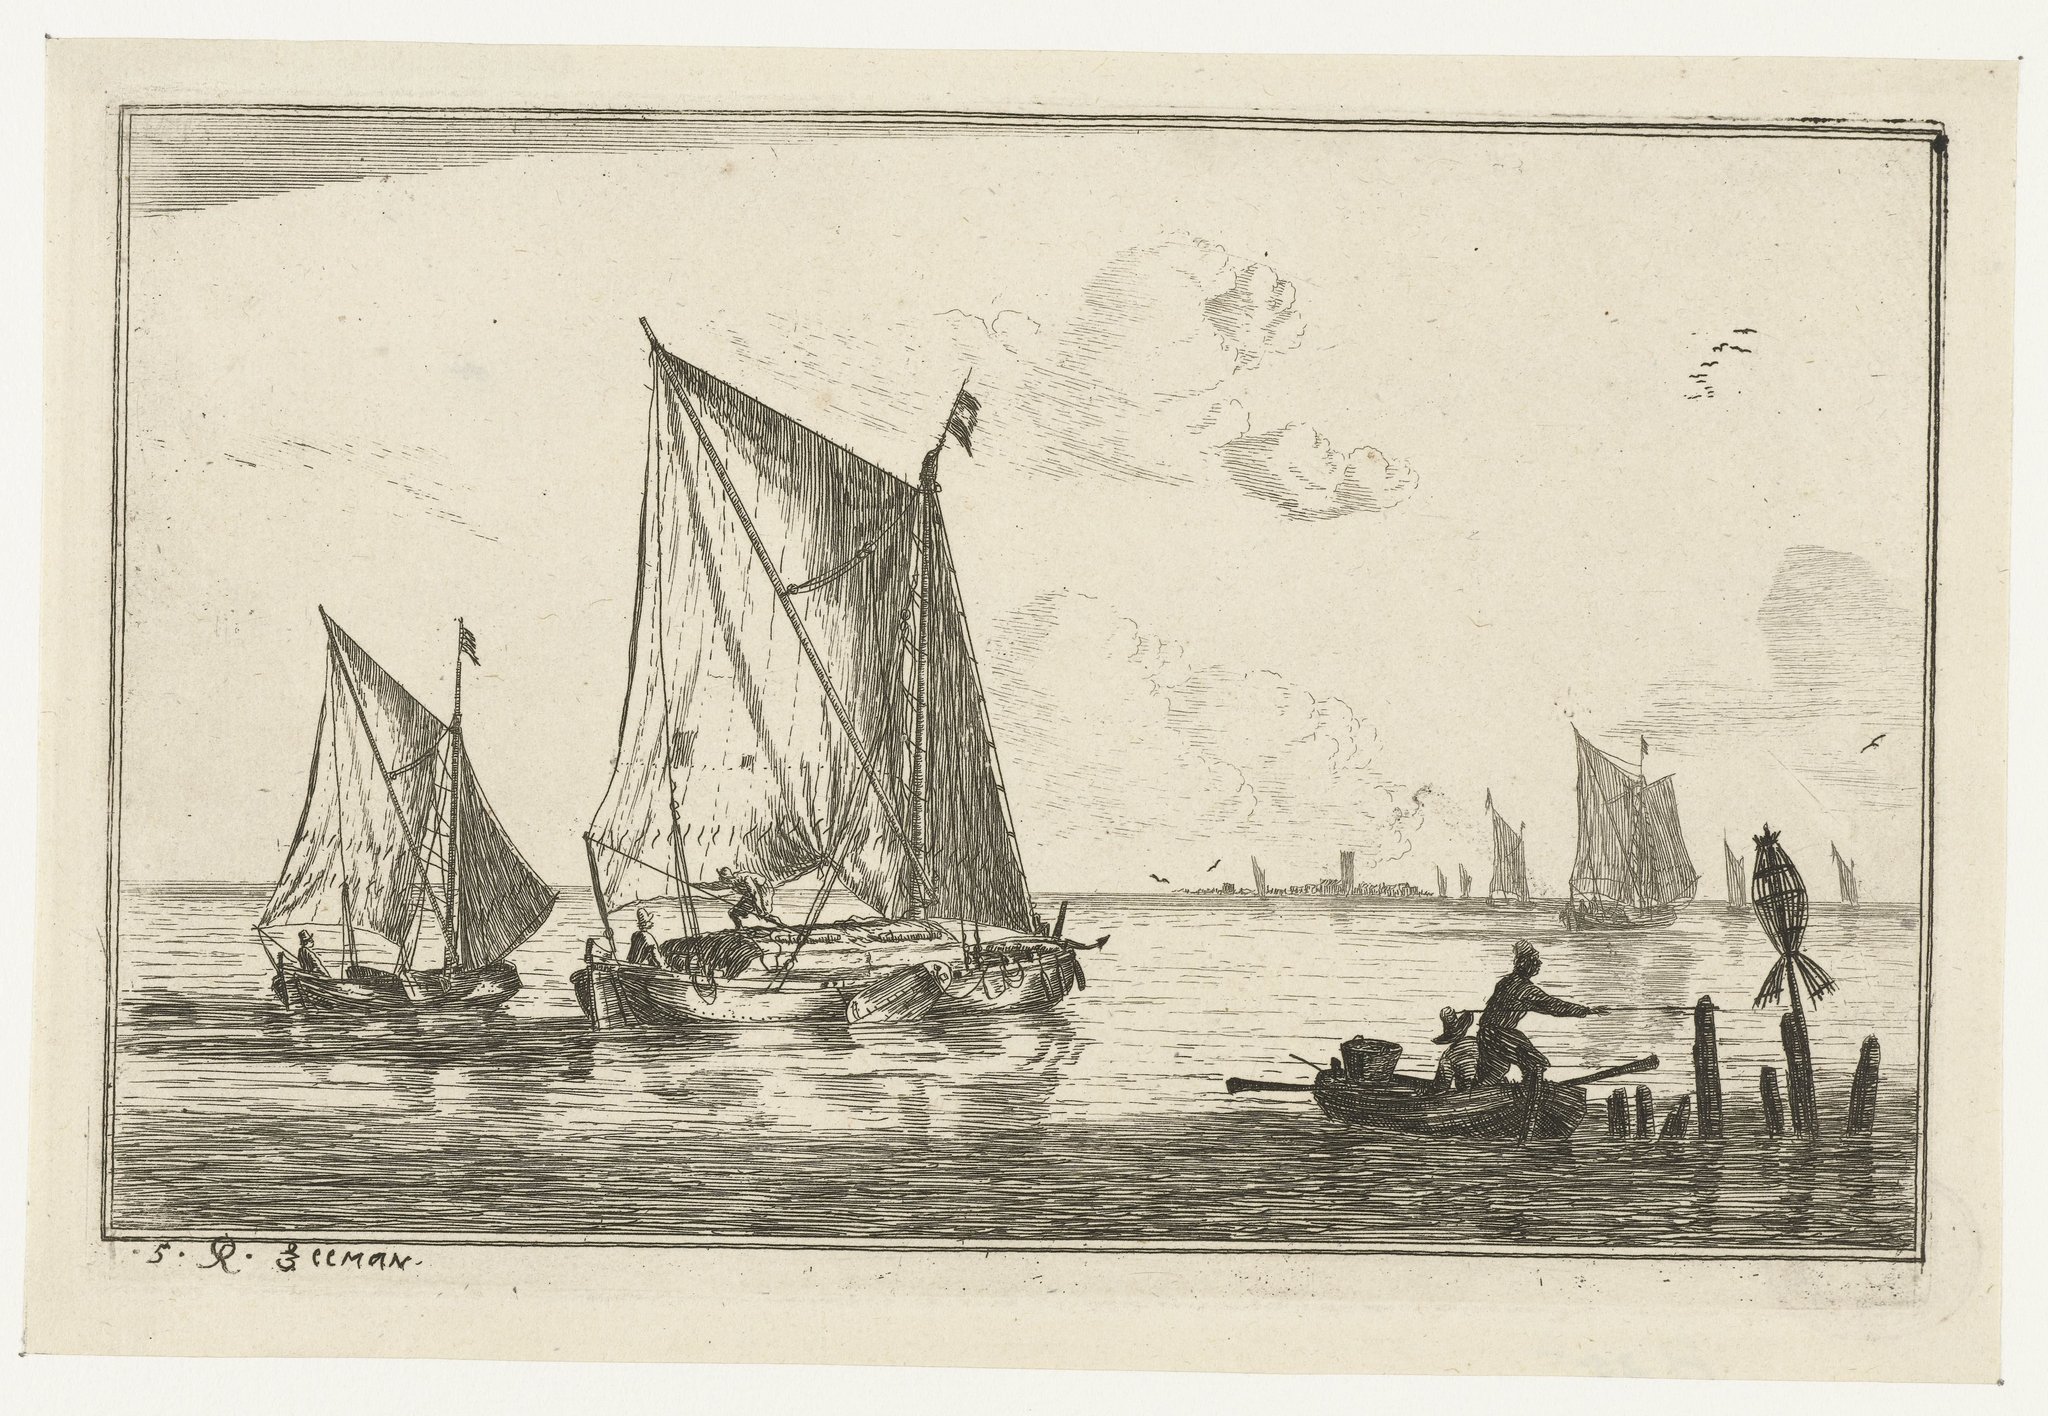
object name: print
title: Twee zeilschepen en een roeiboot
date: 1654-1748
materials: paper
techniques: etching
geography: netherlands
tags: sailing-ship, sailing-boat, rowing-boat, canoe, etc.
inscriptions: collector's mark: Lugt 12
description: Rustig water met twee zeilschepen en een roeiboot. In de verte een aantal boten en de contouren van een stad. Rond de voorstelling een dubbele rand.